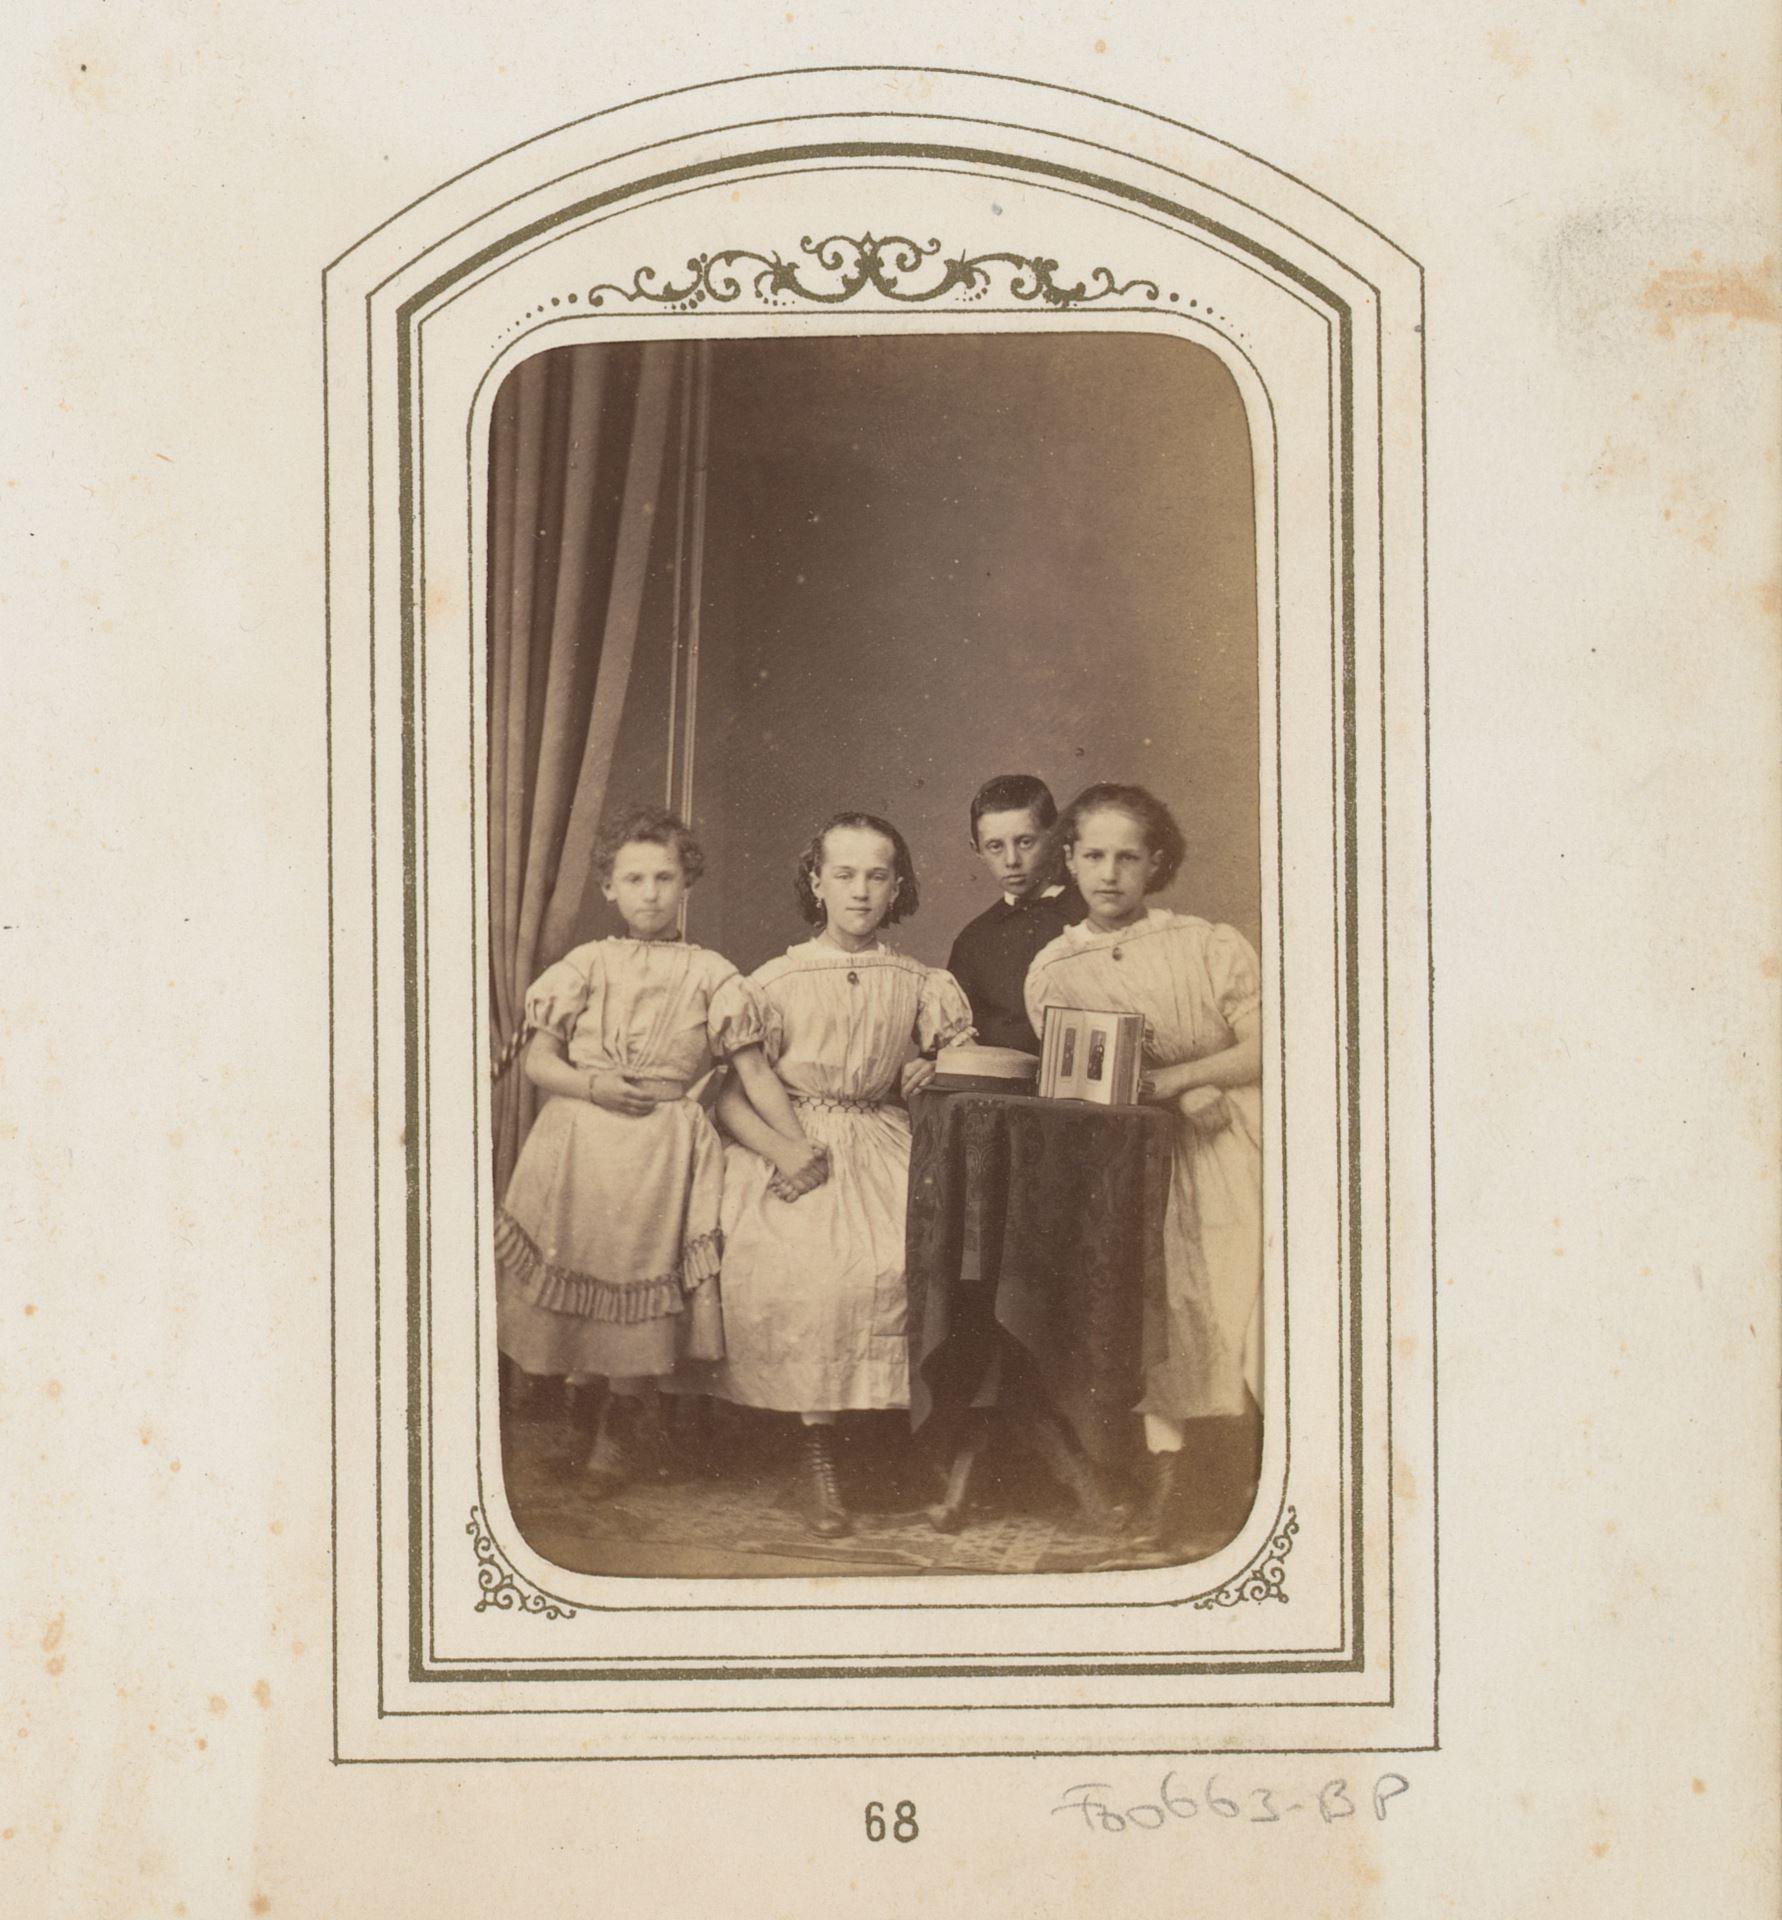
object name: photograph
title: Groepsportret van vier kinderen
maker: roelof loots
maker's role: fotograaf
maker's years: 1814-1898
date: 1860-1880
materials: cardboard, photographic support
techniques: albumen print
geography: medemblik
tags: child, anonymous historical persons portrayed in a group, in a group-portrait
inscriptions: number: ‘68’, inscription: ‘Photographie van R. Loots/ Medemblik’